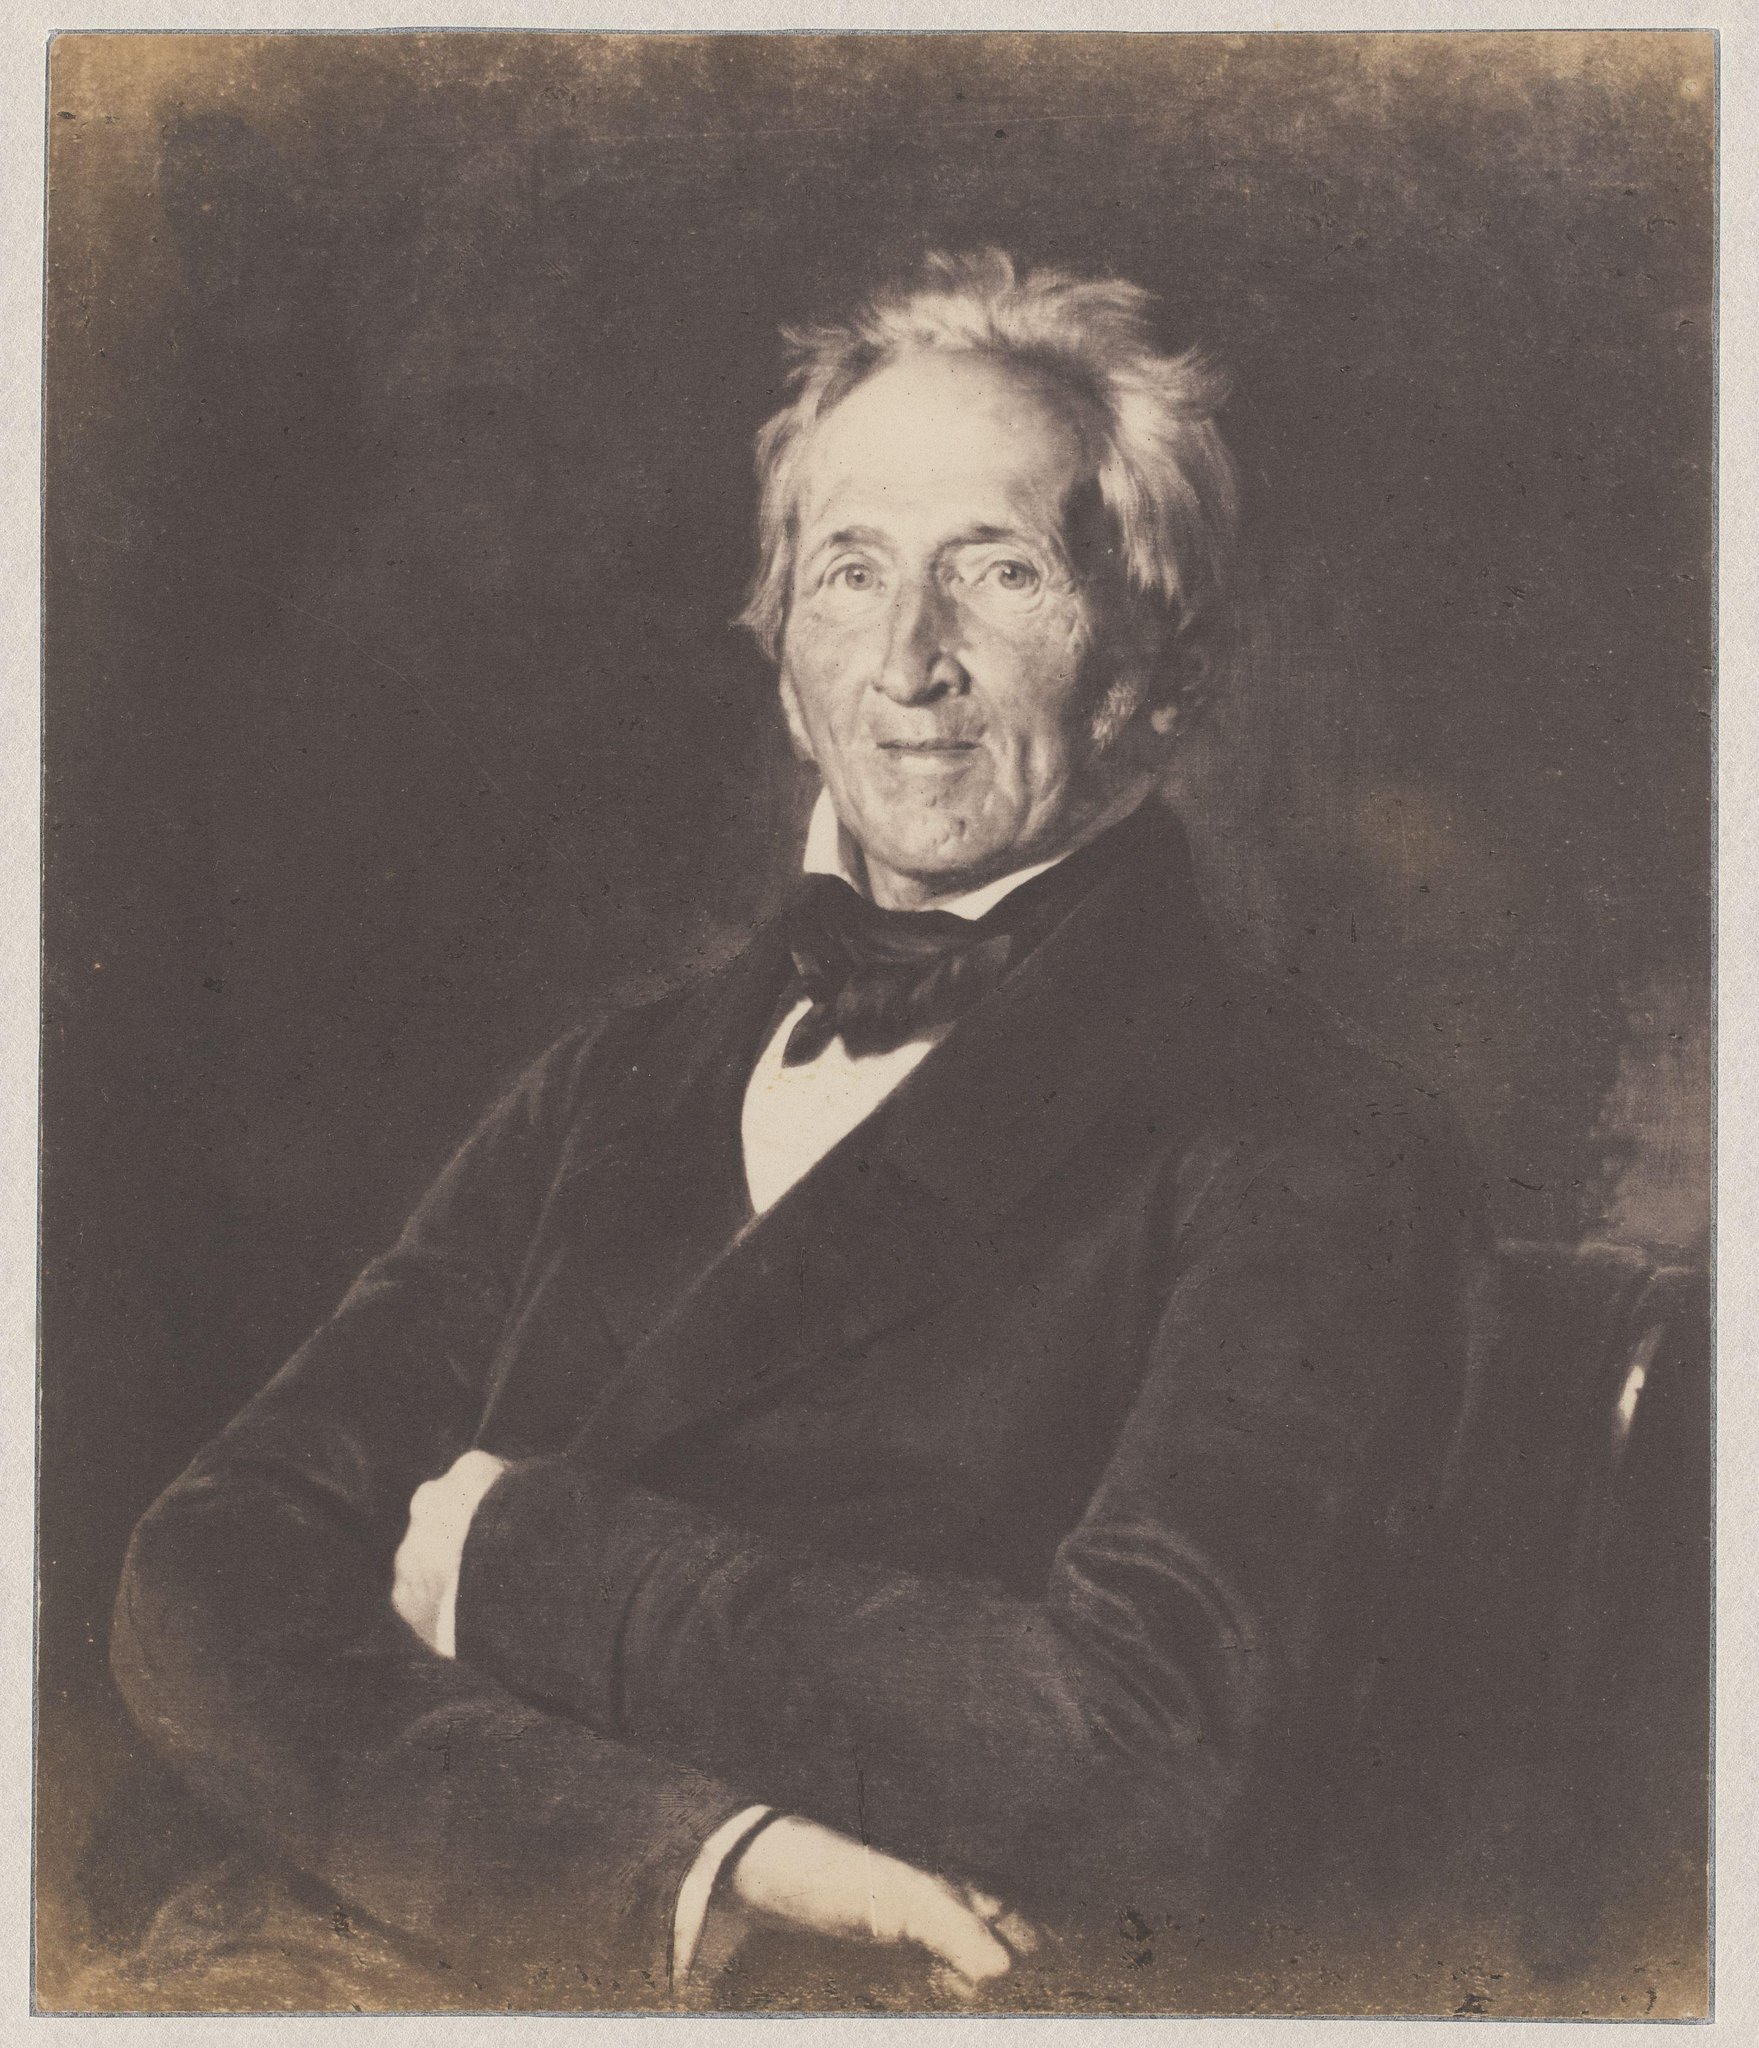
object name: photograph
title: Fotoreproductie van een geschilderd mansportret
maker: franz seraph hanfstaengl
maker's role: painter, print maker, printer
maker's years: 1804-1877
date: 1855-1860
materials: paper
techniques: salted paper print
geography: germany